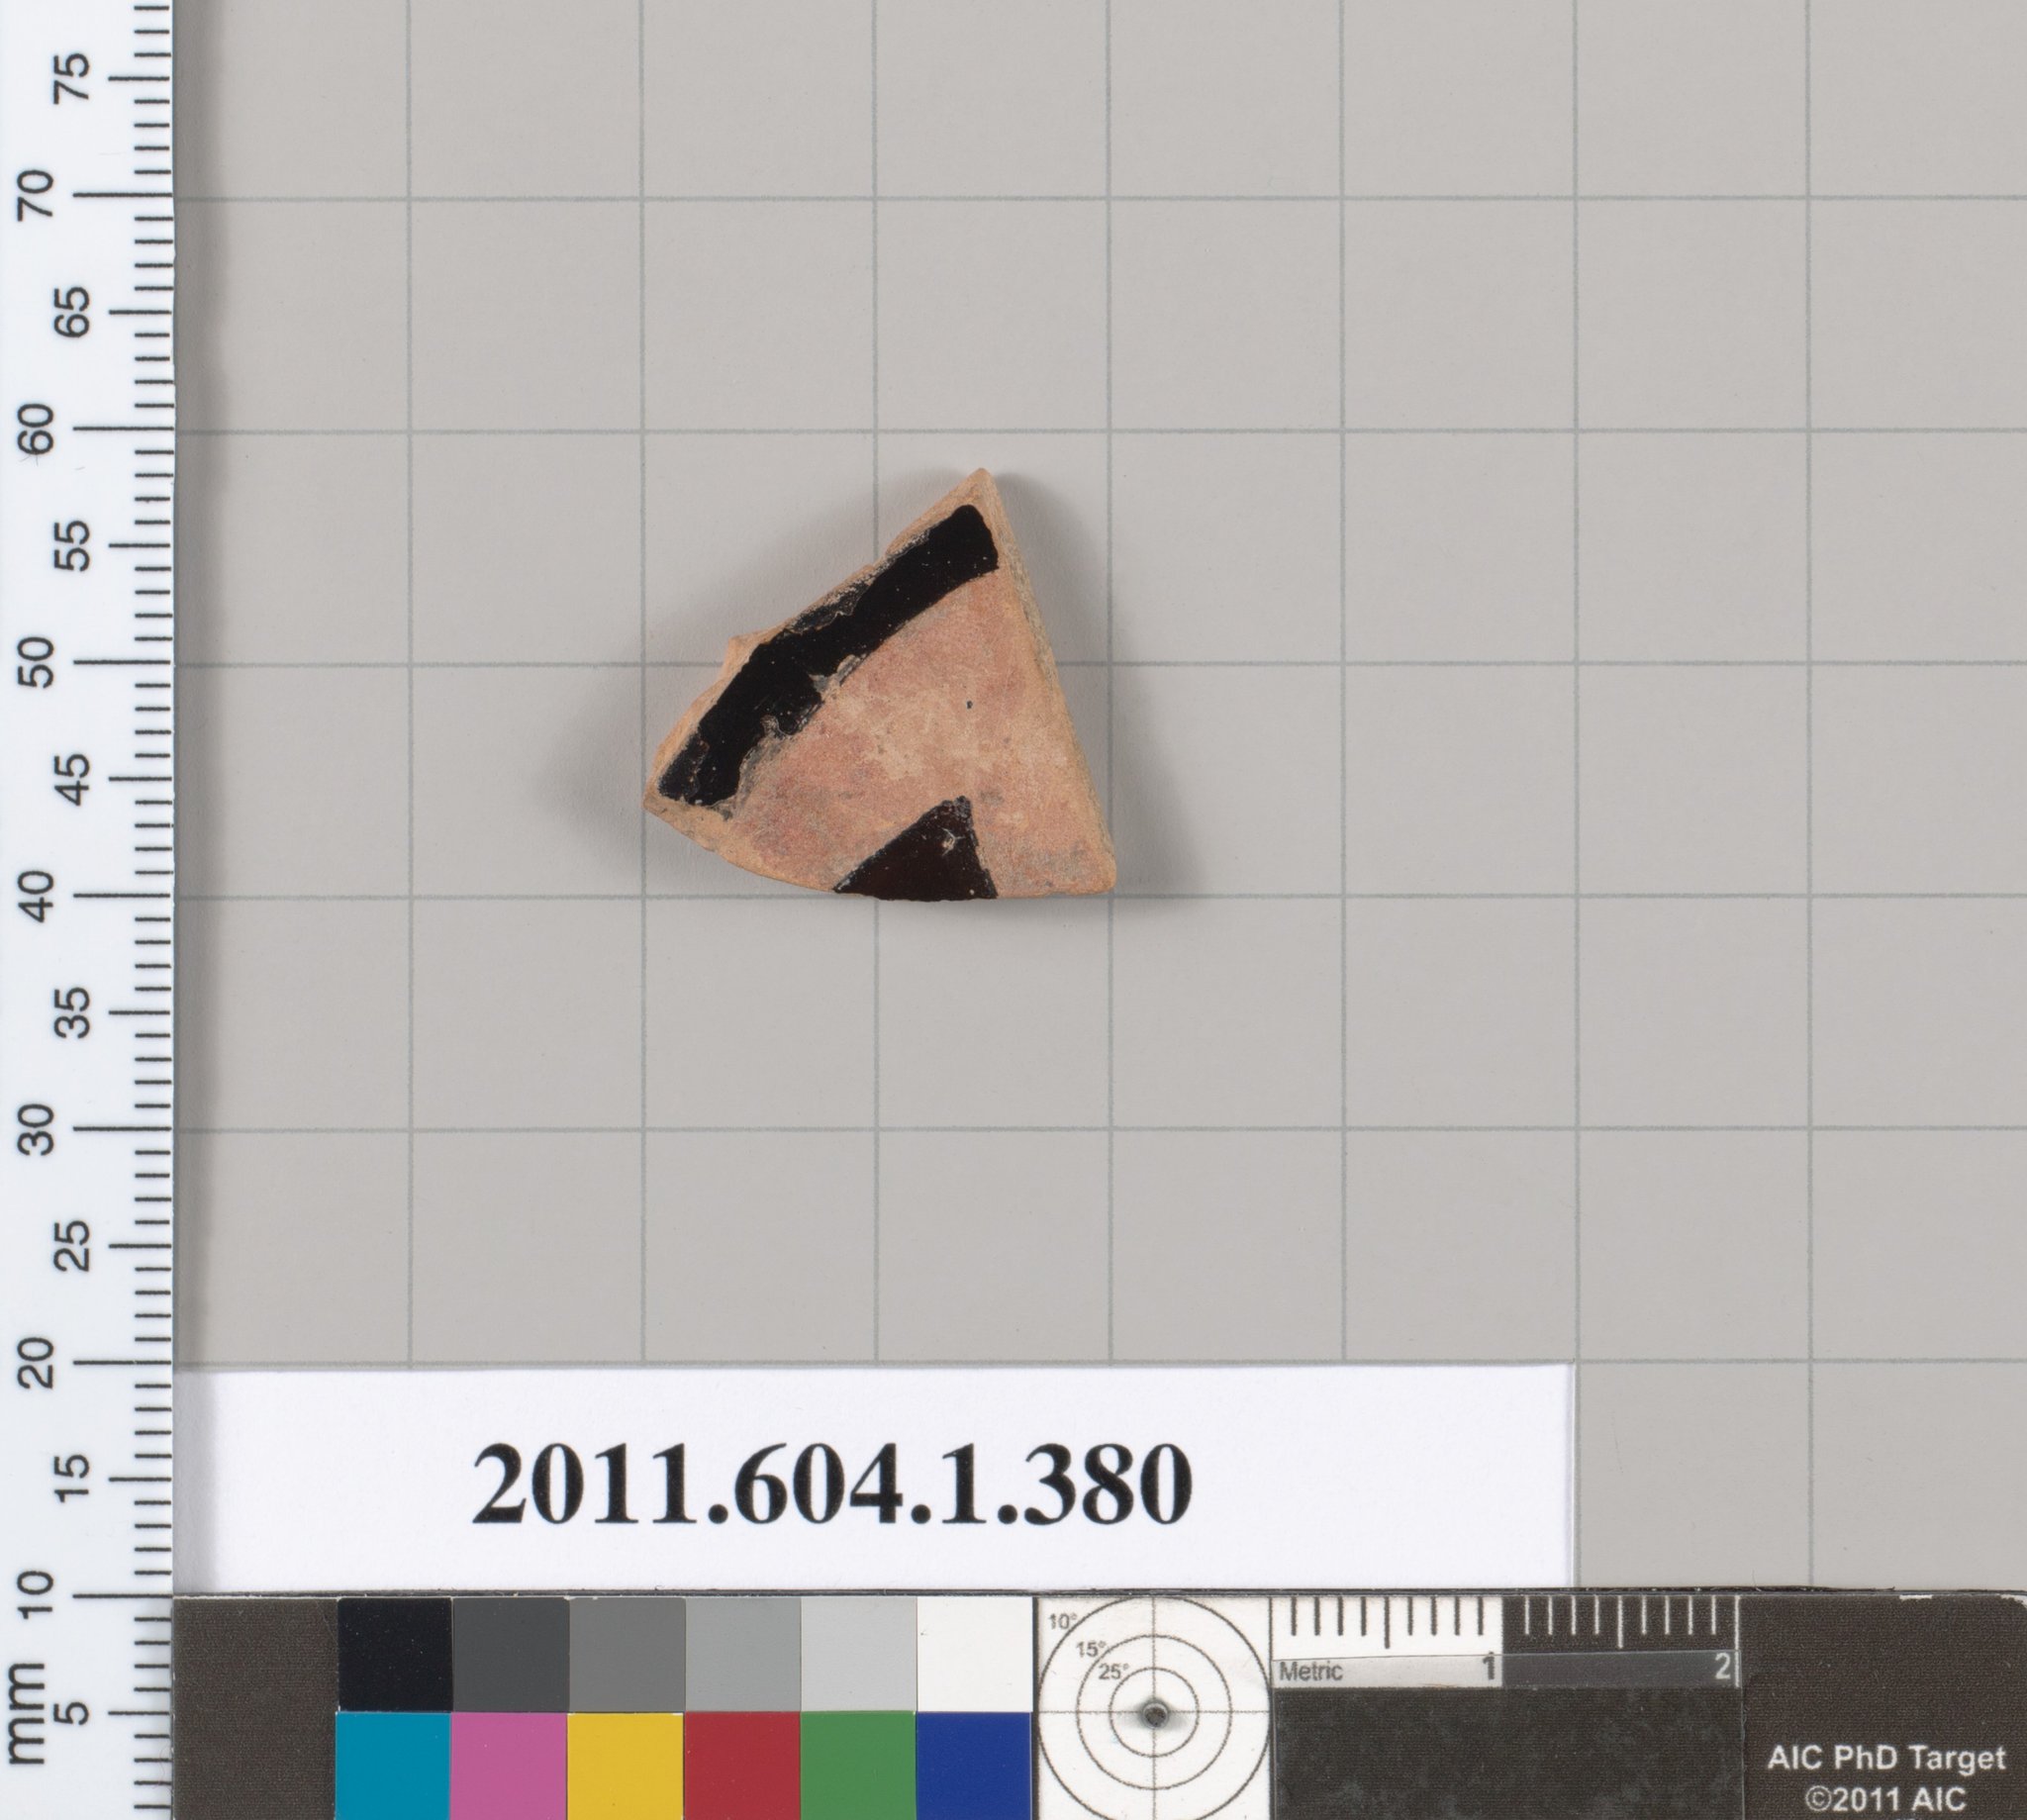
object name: kylix fragment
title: Terracotta fragment of a kylix (drinking cup)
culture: greek, attic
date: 475-451 BCE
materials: terracotta